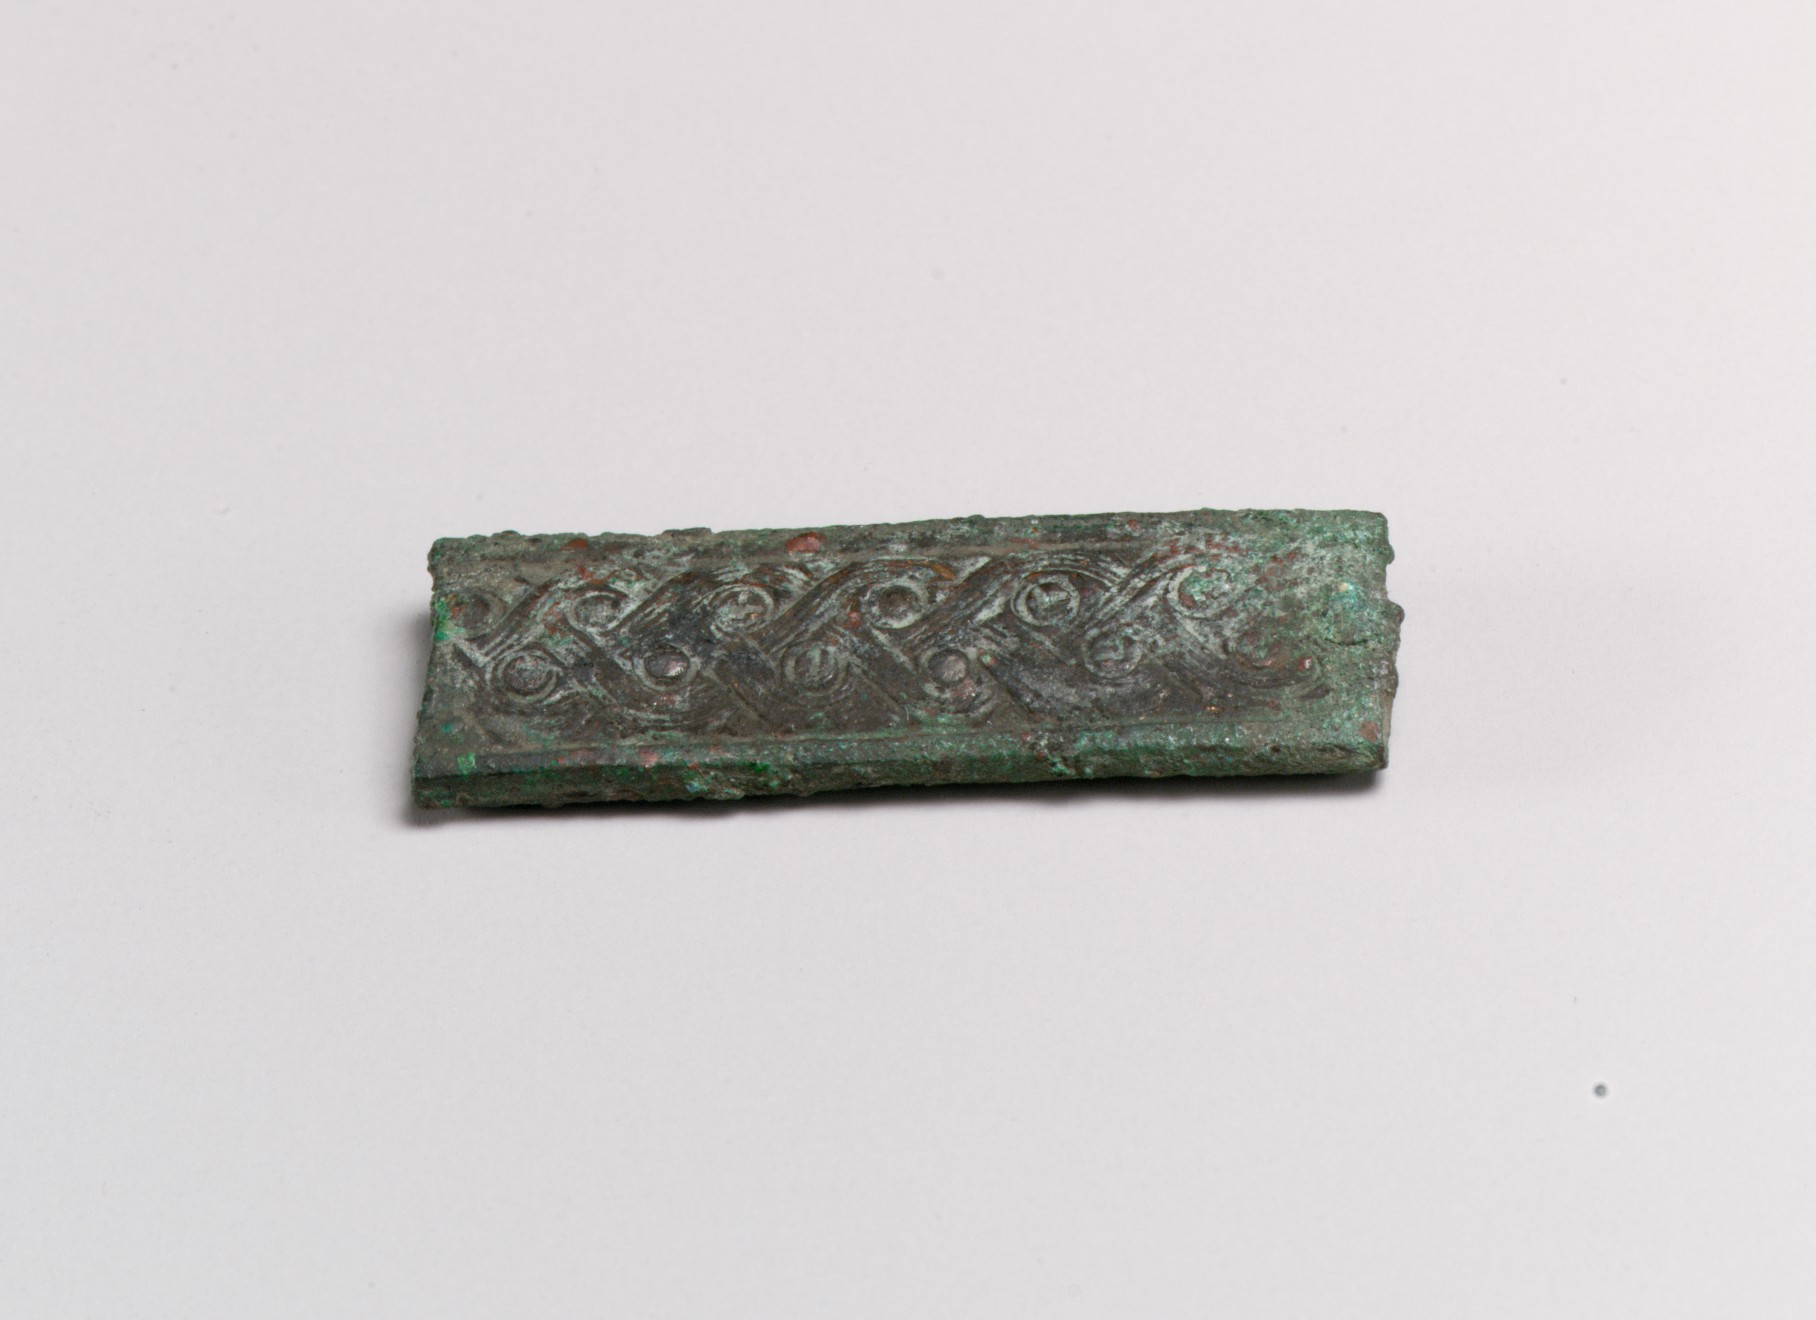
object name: furniture, leg element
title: Furniture, leg elements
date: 7000 BCE-330 CE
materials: bronze